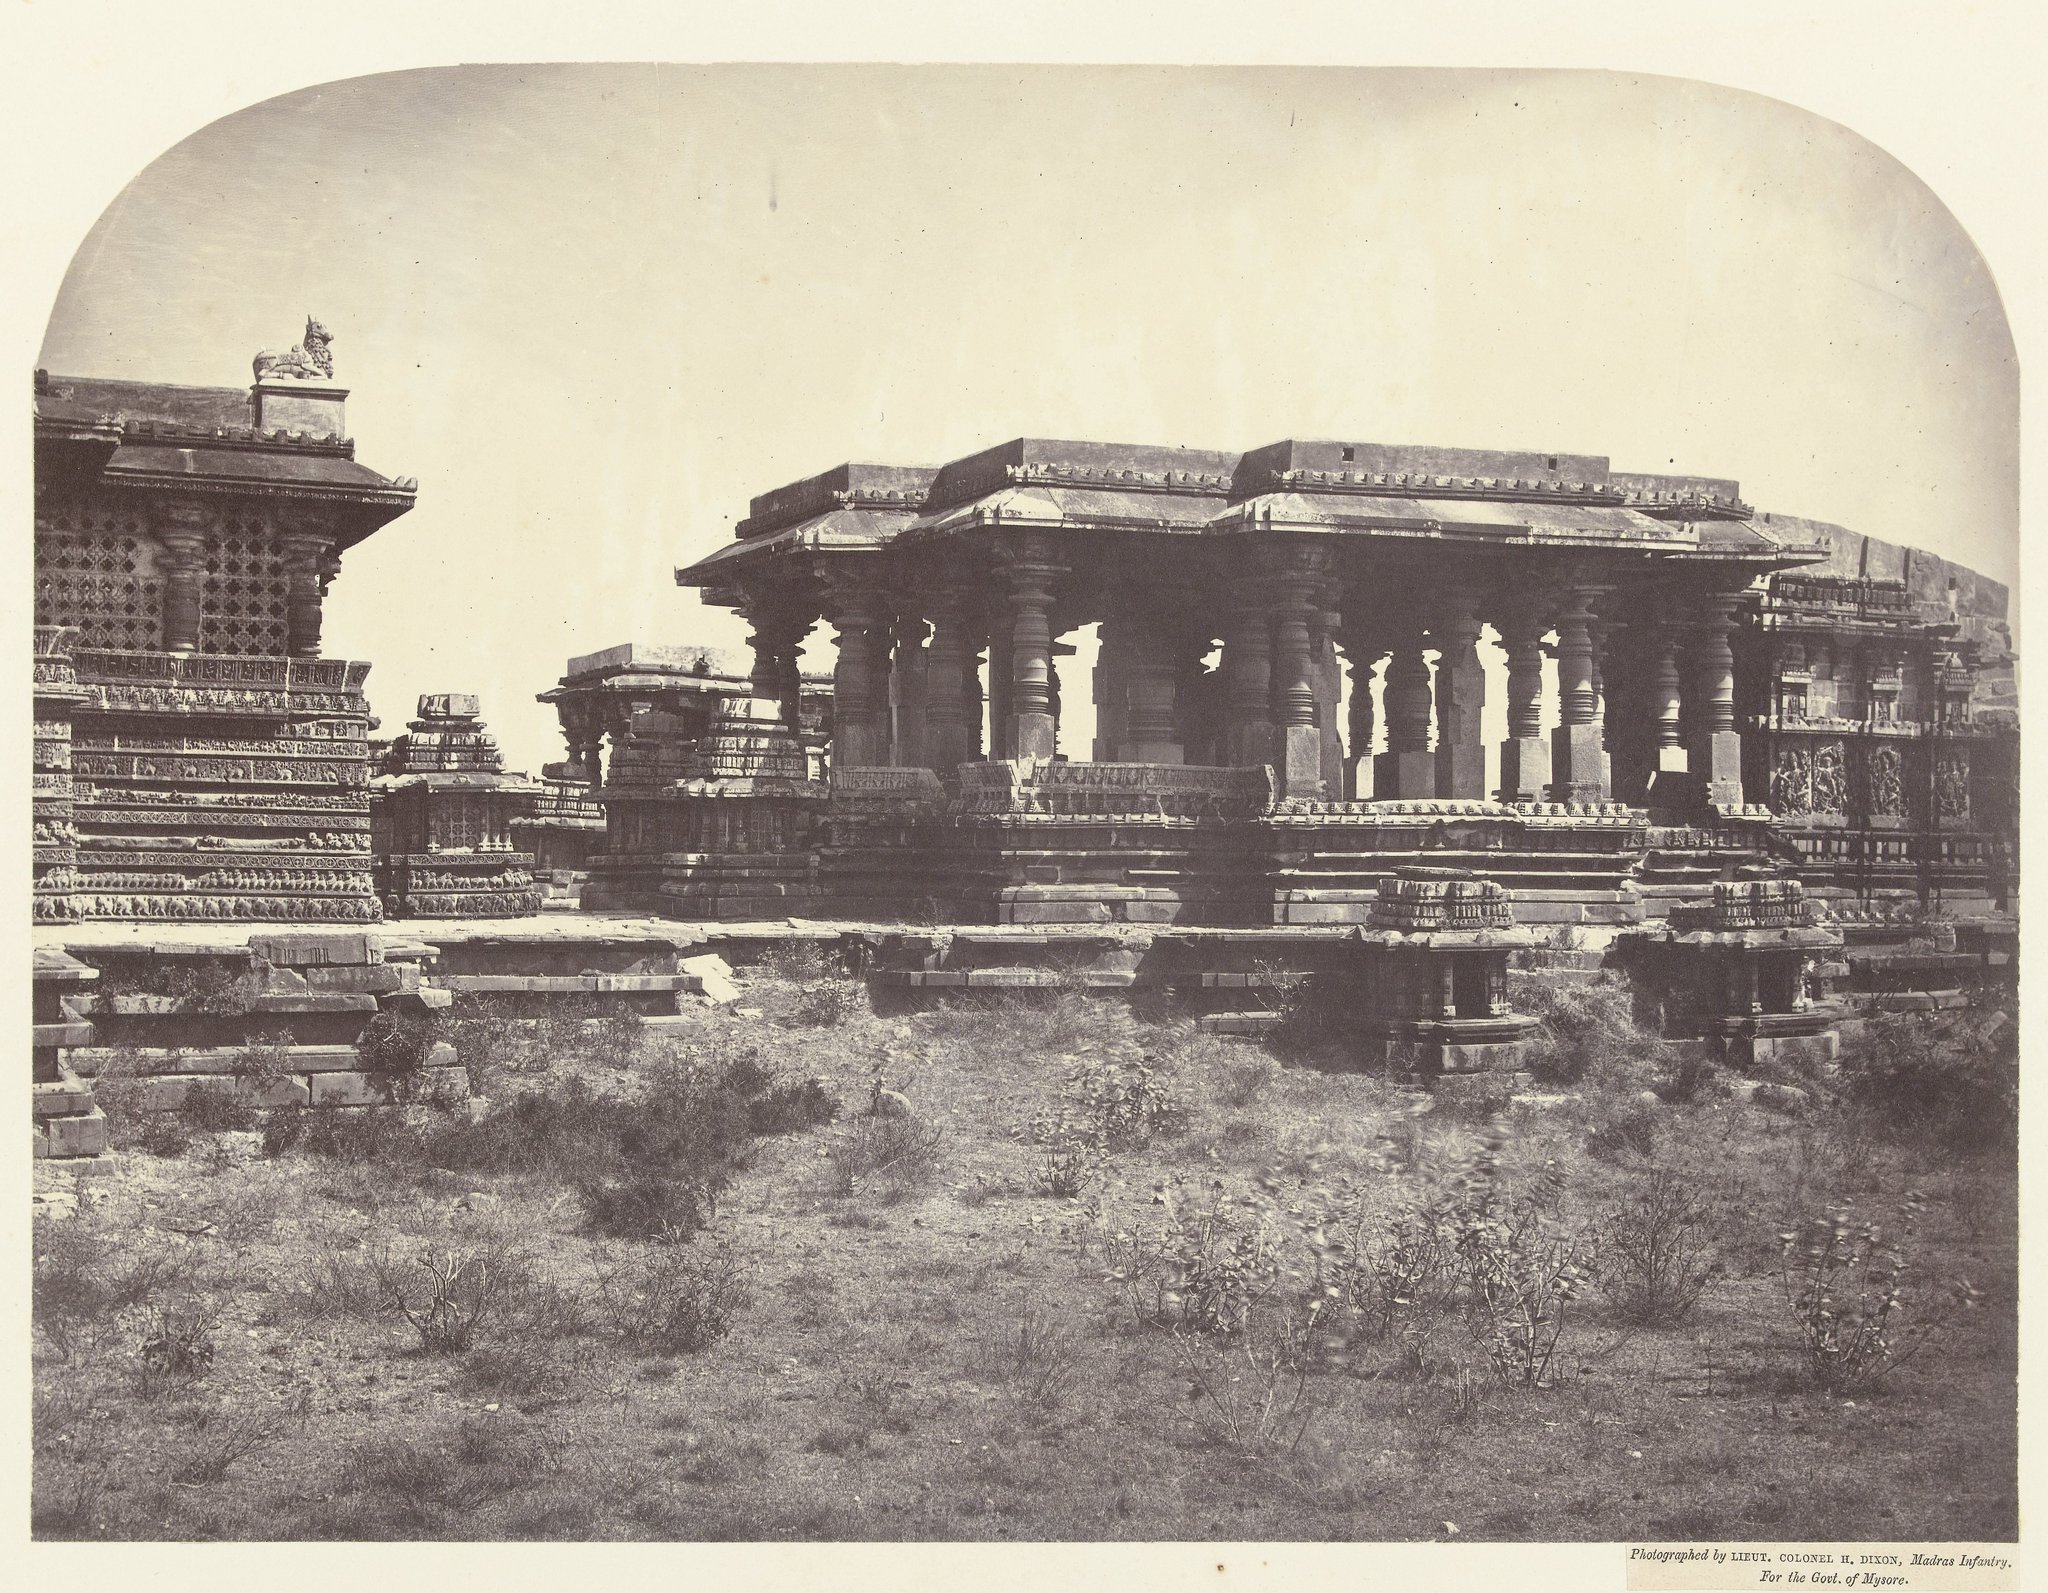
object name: photograph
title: Temple of Helabid. (East front)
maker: henry dixon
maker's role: fotograaf, luitenant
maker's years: 1824-1883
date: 1865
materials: cardboard, paper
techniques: albumen print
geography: mysore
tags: temple, shrine ~ hinduism, buddhism, jainism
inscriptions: inscription: ‘Photographed by LIEUT. COLONEL H. DIXON, Madras Infantry/ For the Govt. of Mysore.’, inscription: ‘Right view/ 27’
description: Niet te verwarren met Henry Dixon (1820-1983, RP-F-1996-260); de hier bedoelde Henry Dixon was luitenant-kolonel in het Engelse leger. Dixon werd na 1868 bevorderd tot Lieutenant-Colonel en ging in 1872 - in die rang - met pensioen (History of Photography 1981, pp. 129-131)